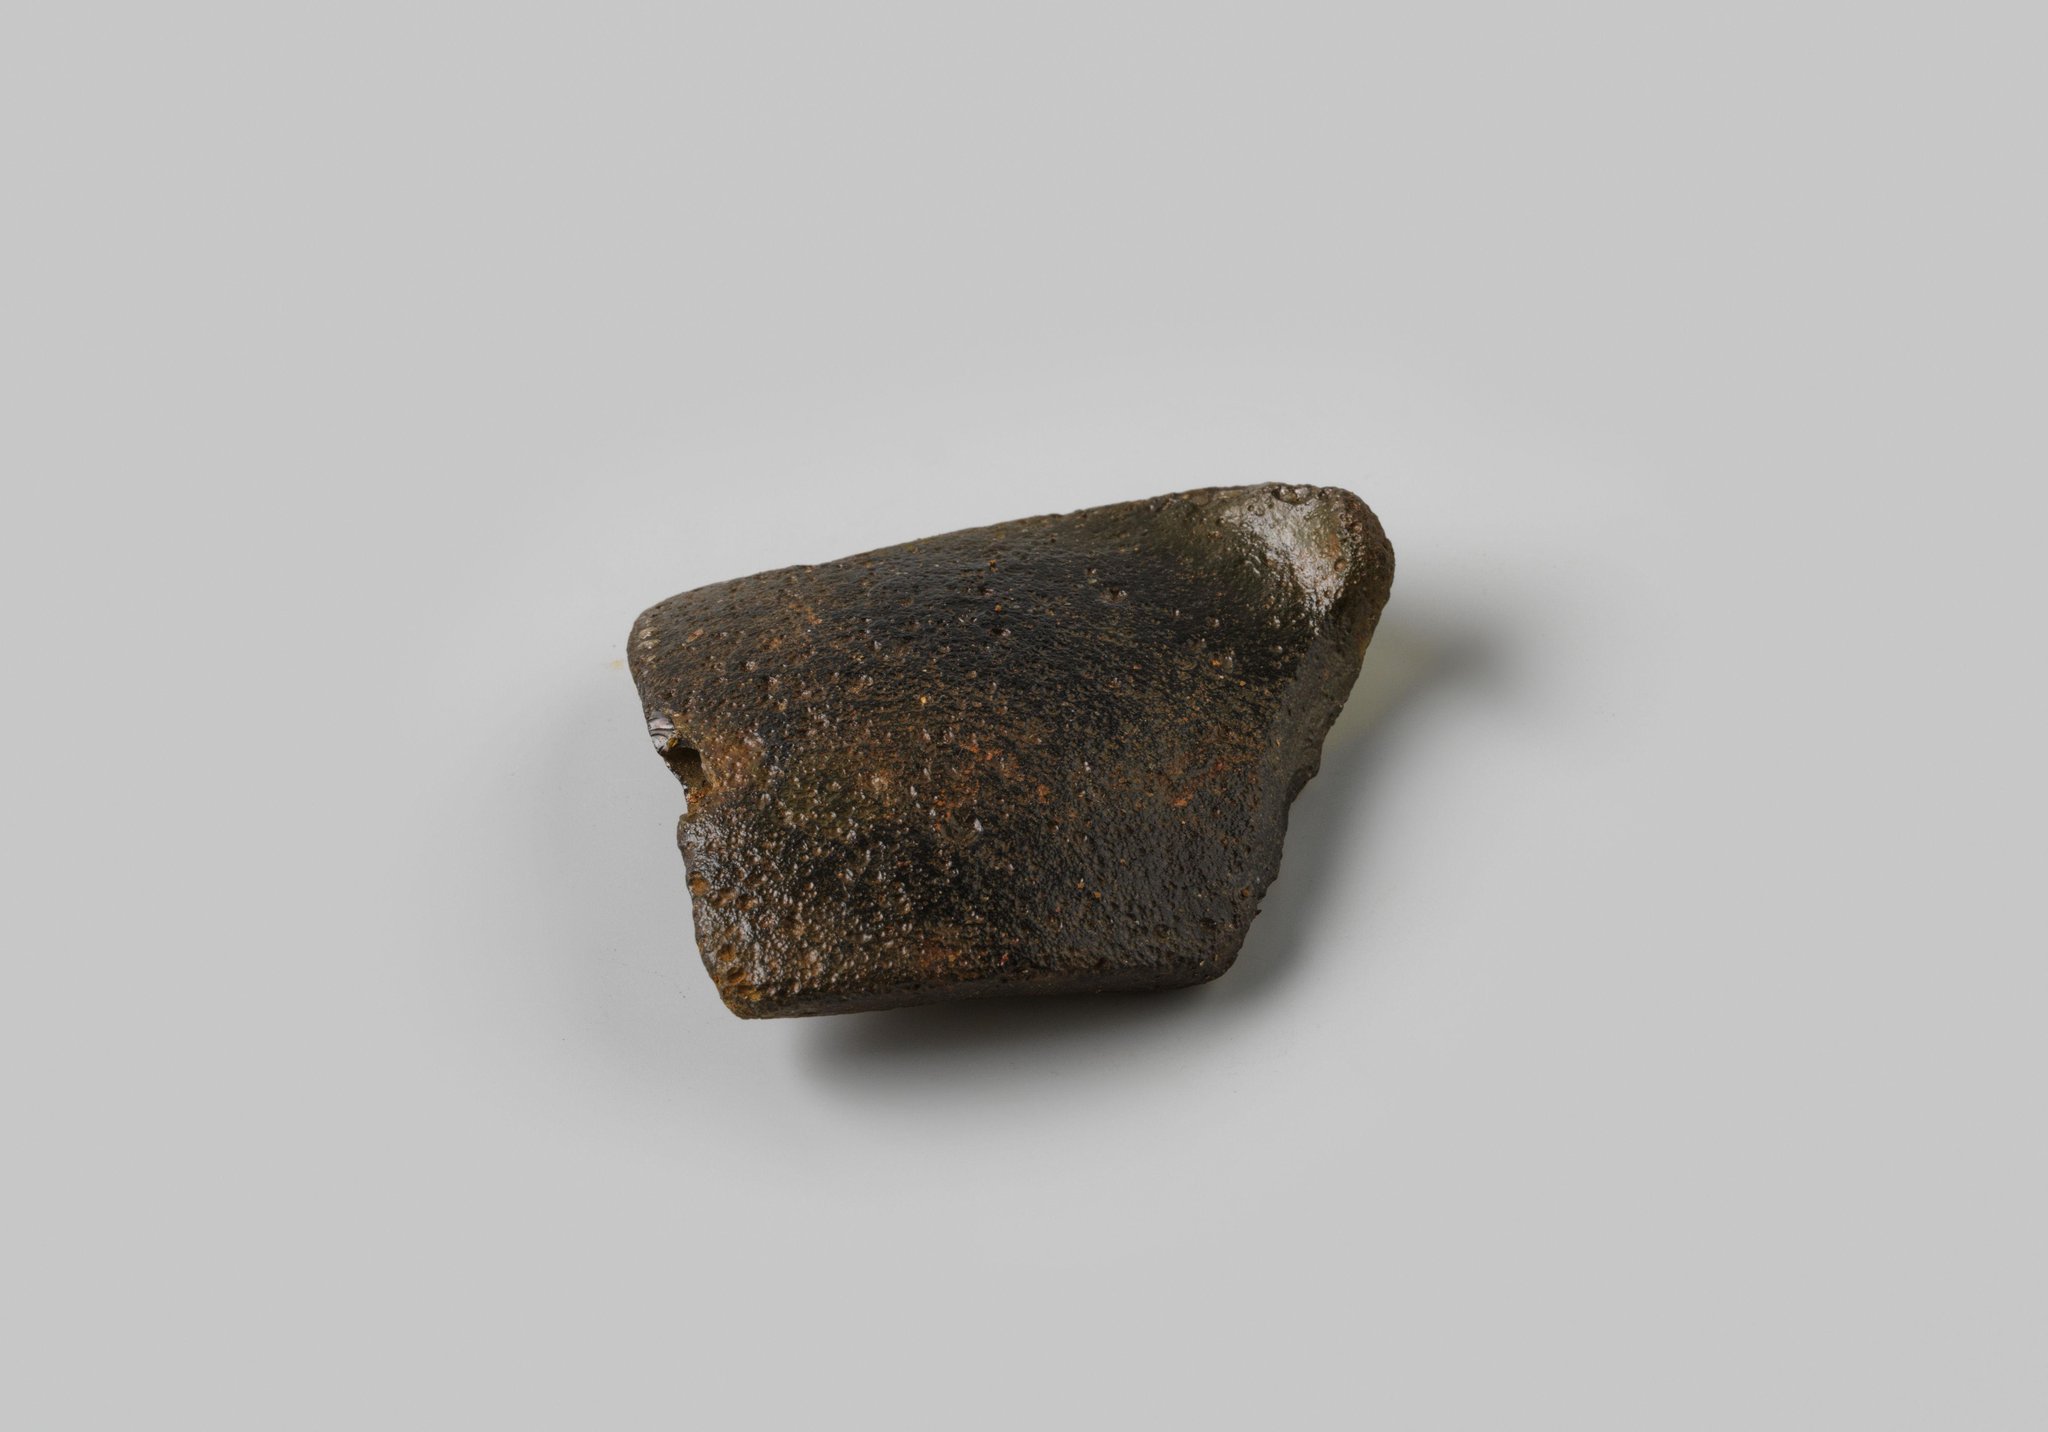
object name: sherd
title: Scherf van een wijnfles uit het wrak van de Oost-Indiëvaarder Hollandia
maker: Anonymous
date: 1700-1743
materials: glass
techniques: green glass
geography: netherlands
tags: verenigde oostindische compagnie, hollandia (schip), annet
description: Typologically not identifiable, base, fragm.